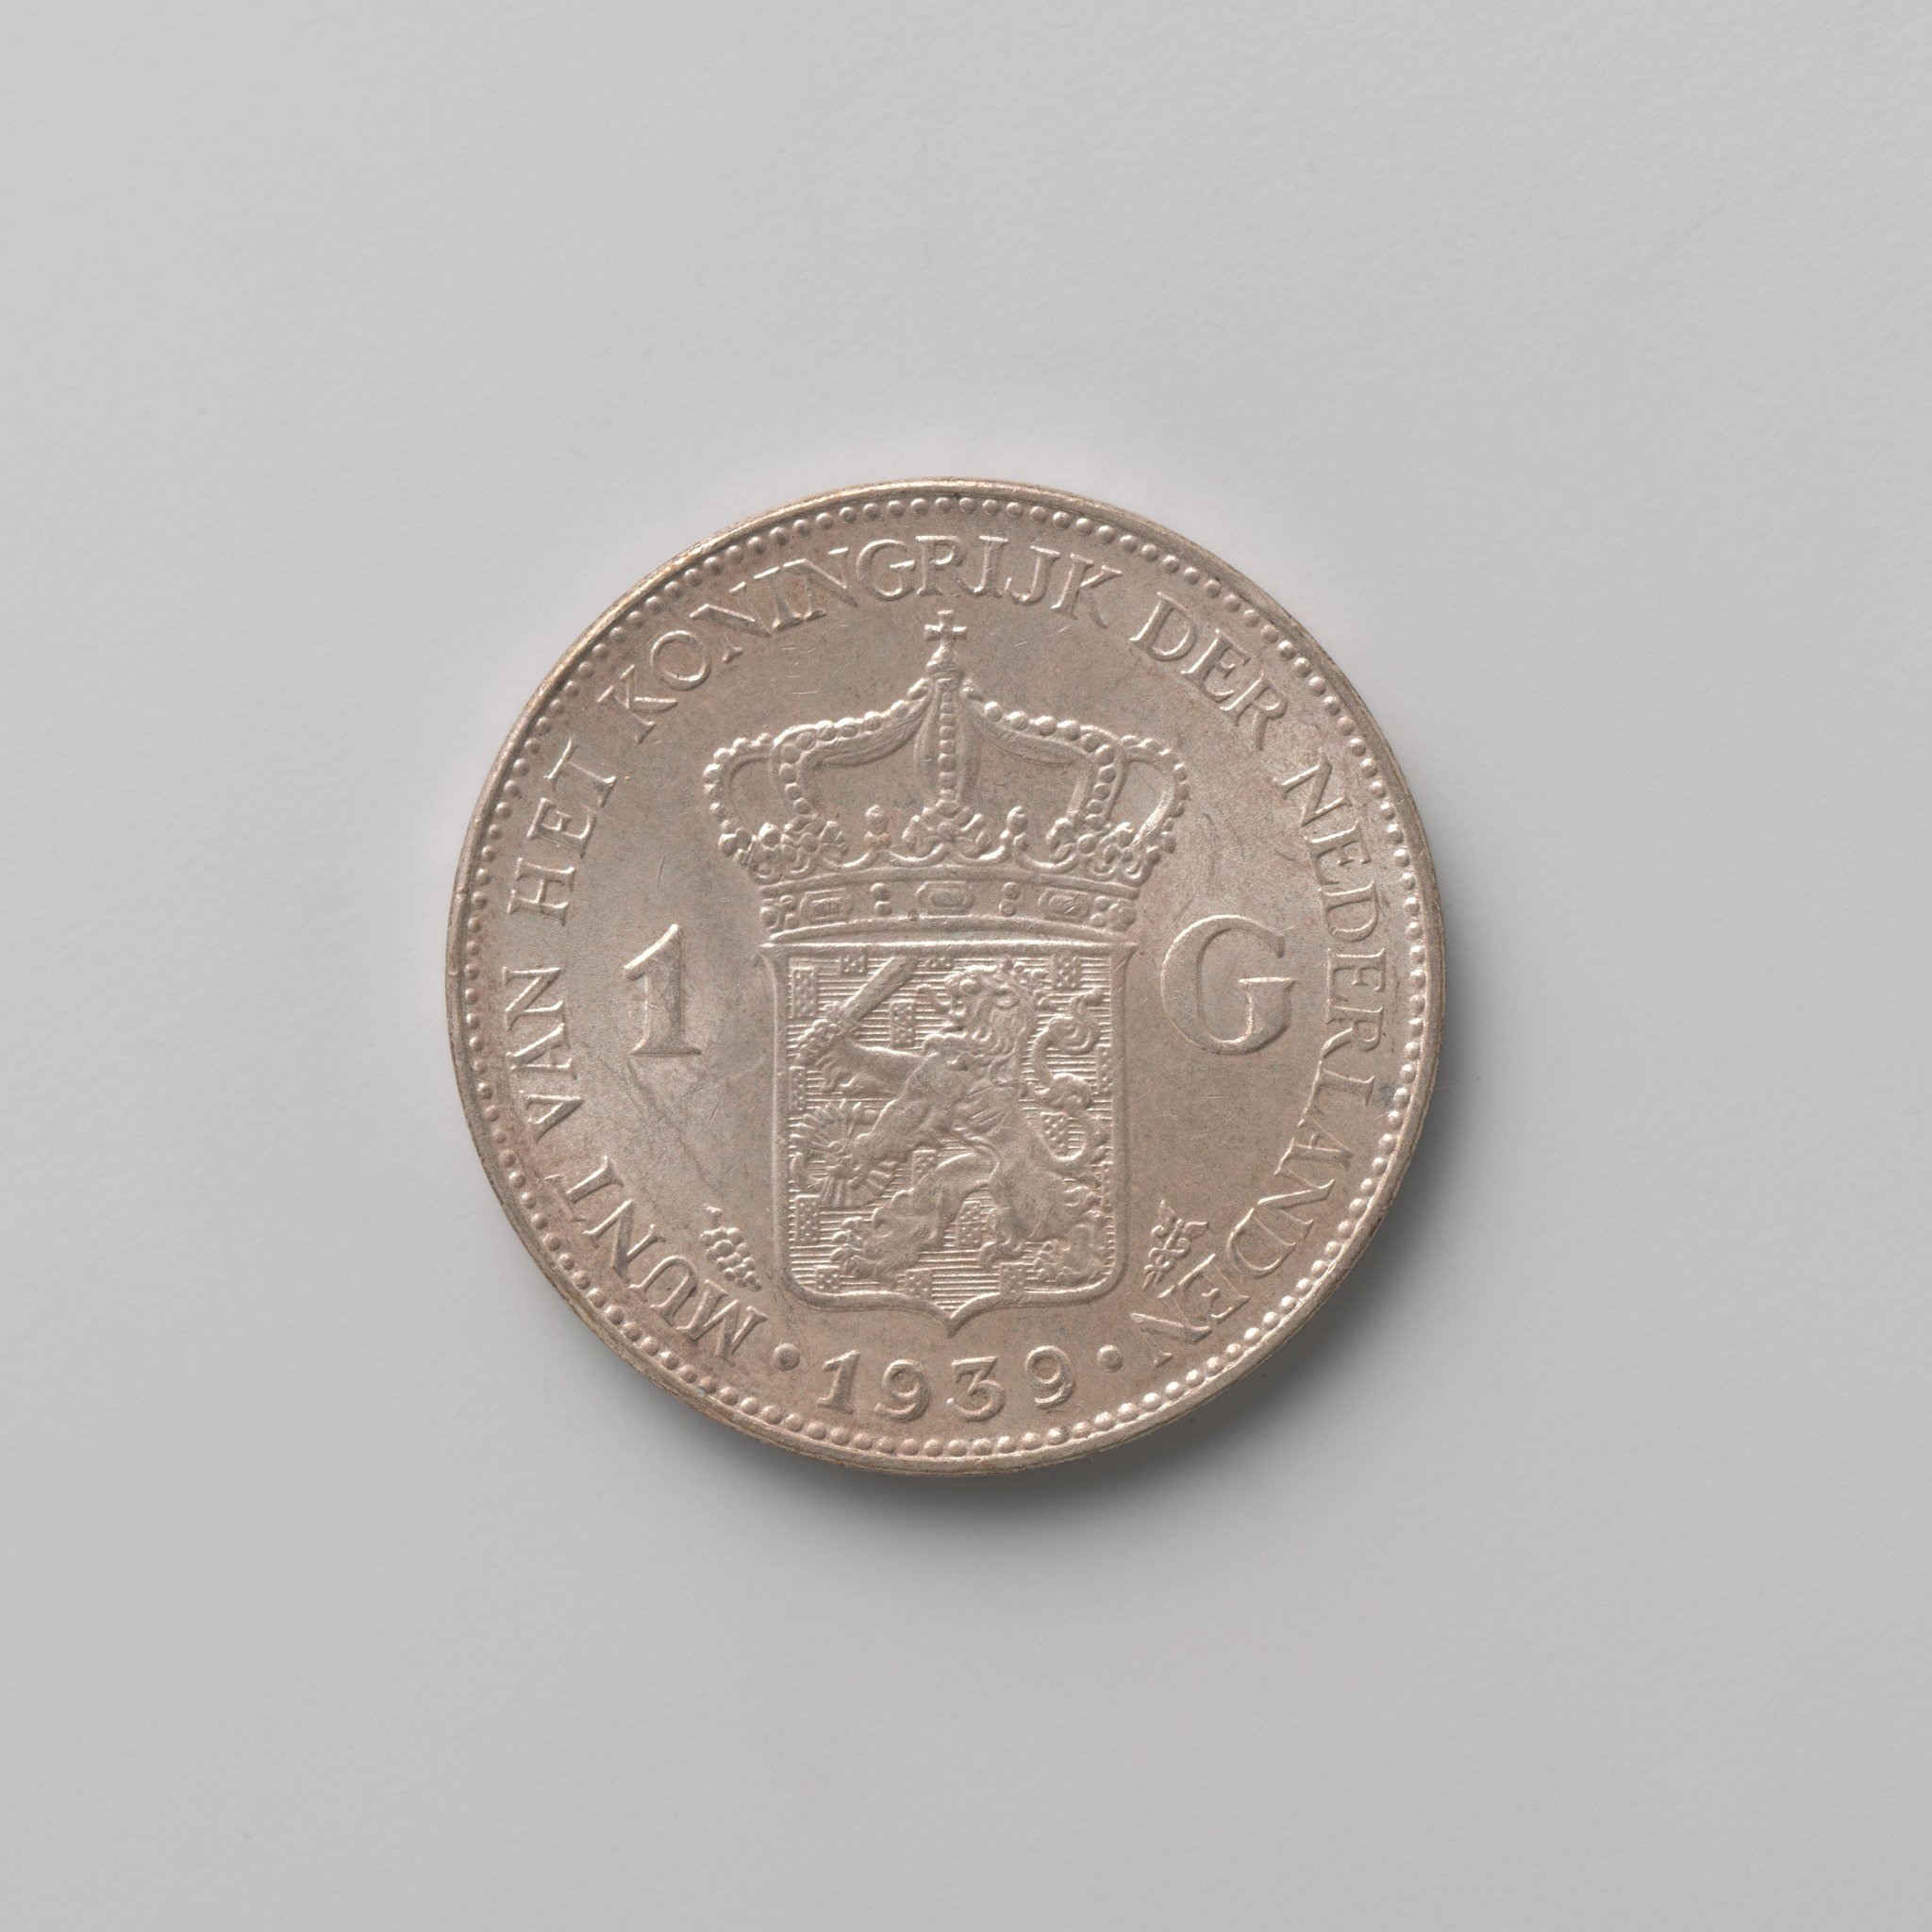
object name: coin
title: Nederland, gulden,1939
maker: wilhelmina of the netherlands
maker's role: print maker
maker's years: 1880-1962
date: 1939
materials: silver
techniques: striking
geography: utrecht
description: Zilveren munt. Voorzijde: hoofd naar links. Keerzijde: tussen waarde-aanduiding 1 G gekroond rijkswapenschild. Jaartal onderaan in omschrift. Randschrift.